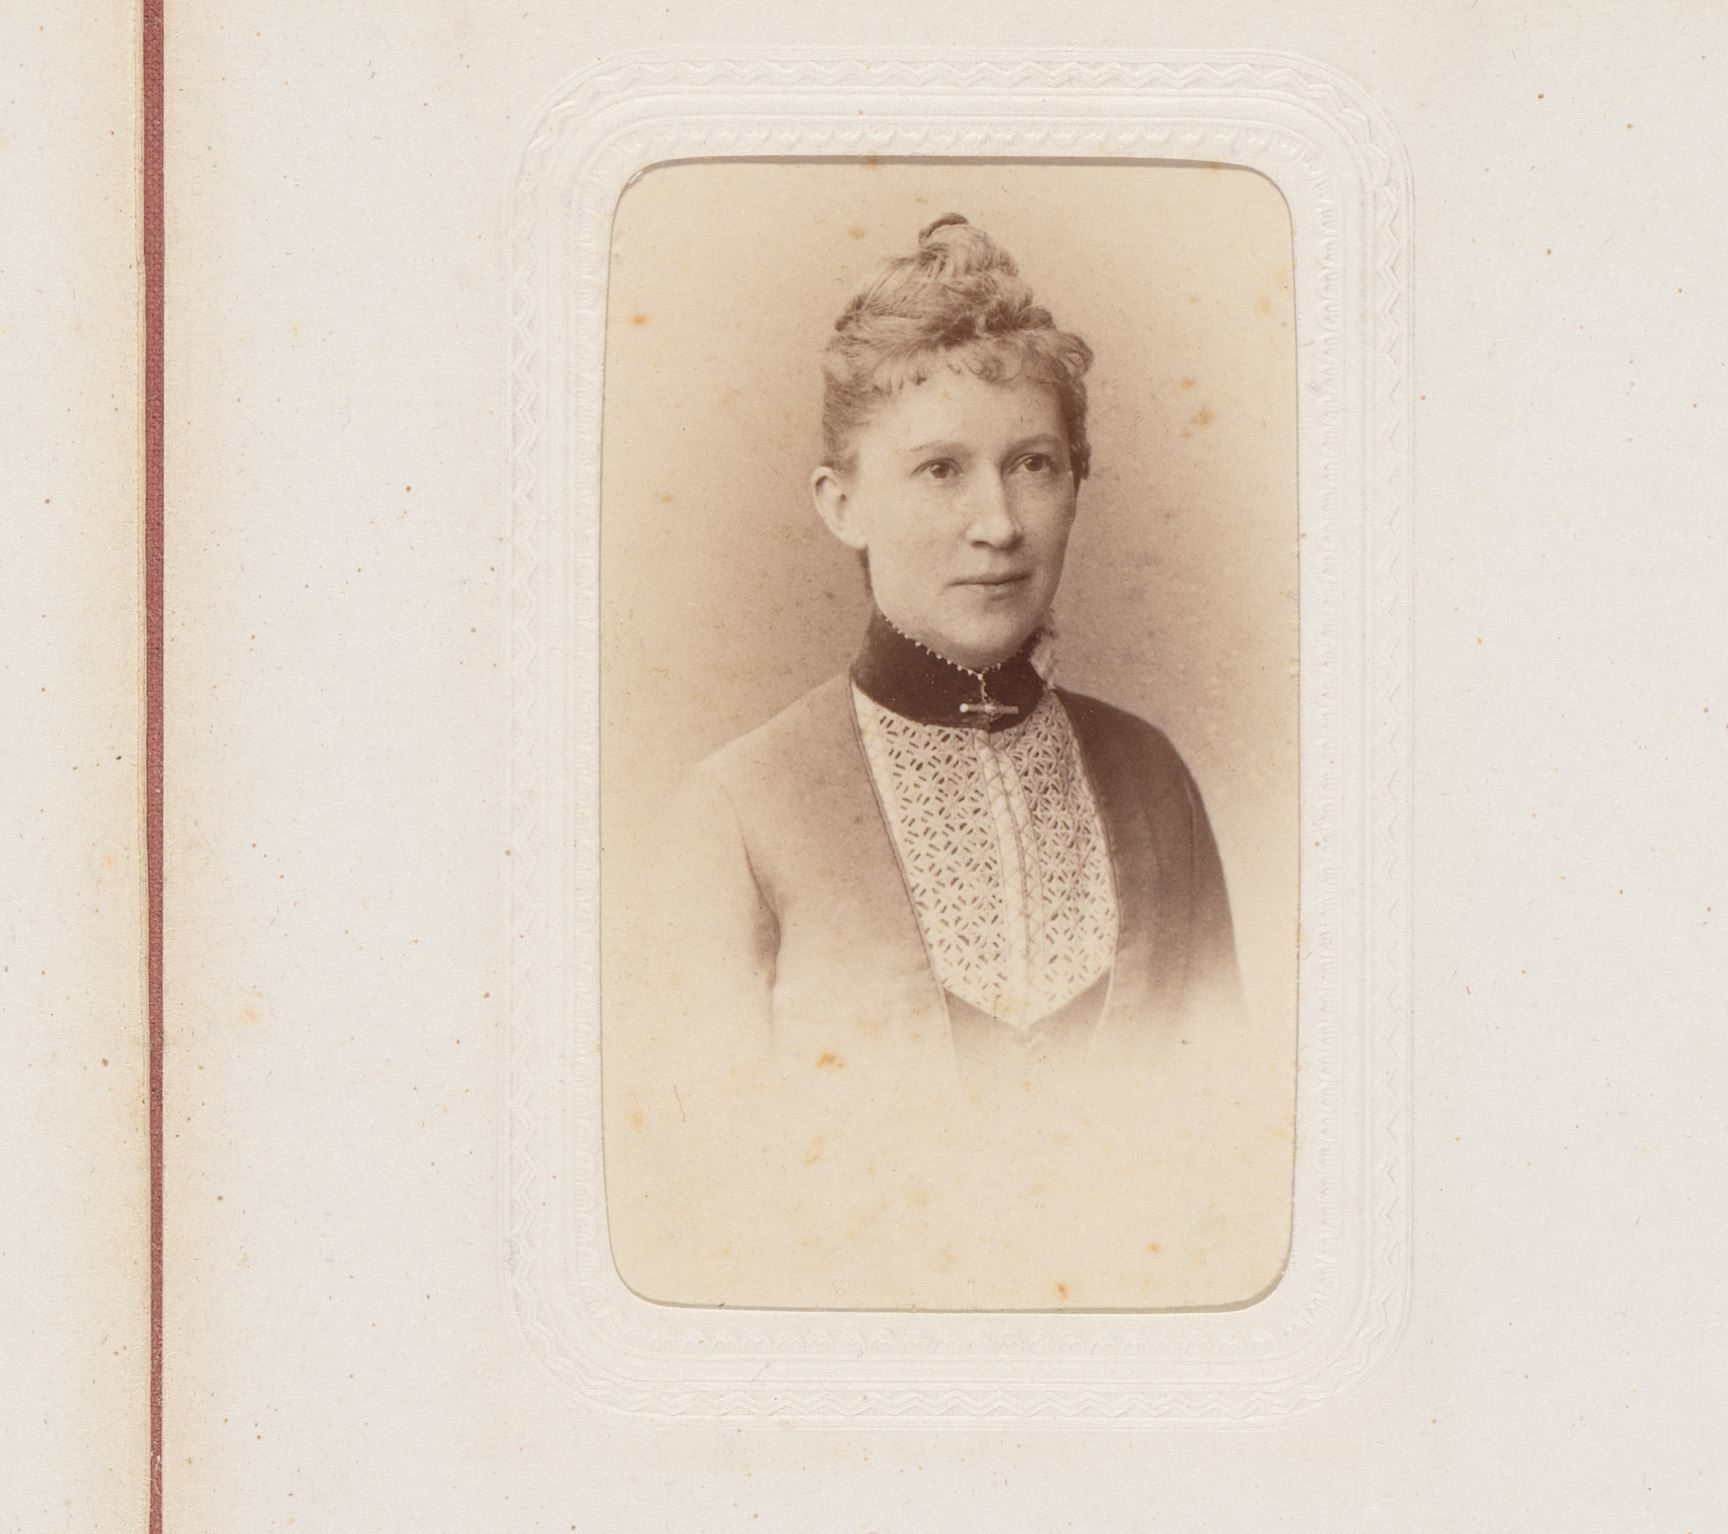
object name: photograph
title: Portret van een vrouw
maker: louis oskar grienwaldt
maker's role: fotograaf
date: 1881-1900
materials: cardboard, photographic support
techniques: albumen print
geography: bremen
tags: historical persons - bb - woman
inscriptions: inscription: ‘(...)/ L.O. GRIENWALDT/ Photograph. Institut/ BREMEN/ WALL 86./ (...)/ Prämiirt:/ Hannover, Melbourne, Hamburg,/ Nürnberg, Utrecht,/ Eisenach.’